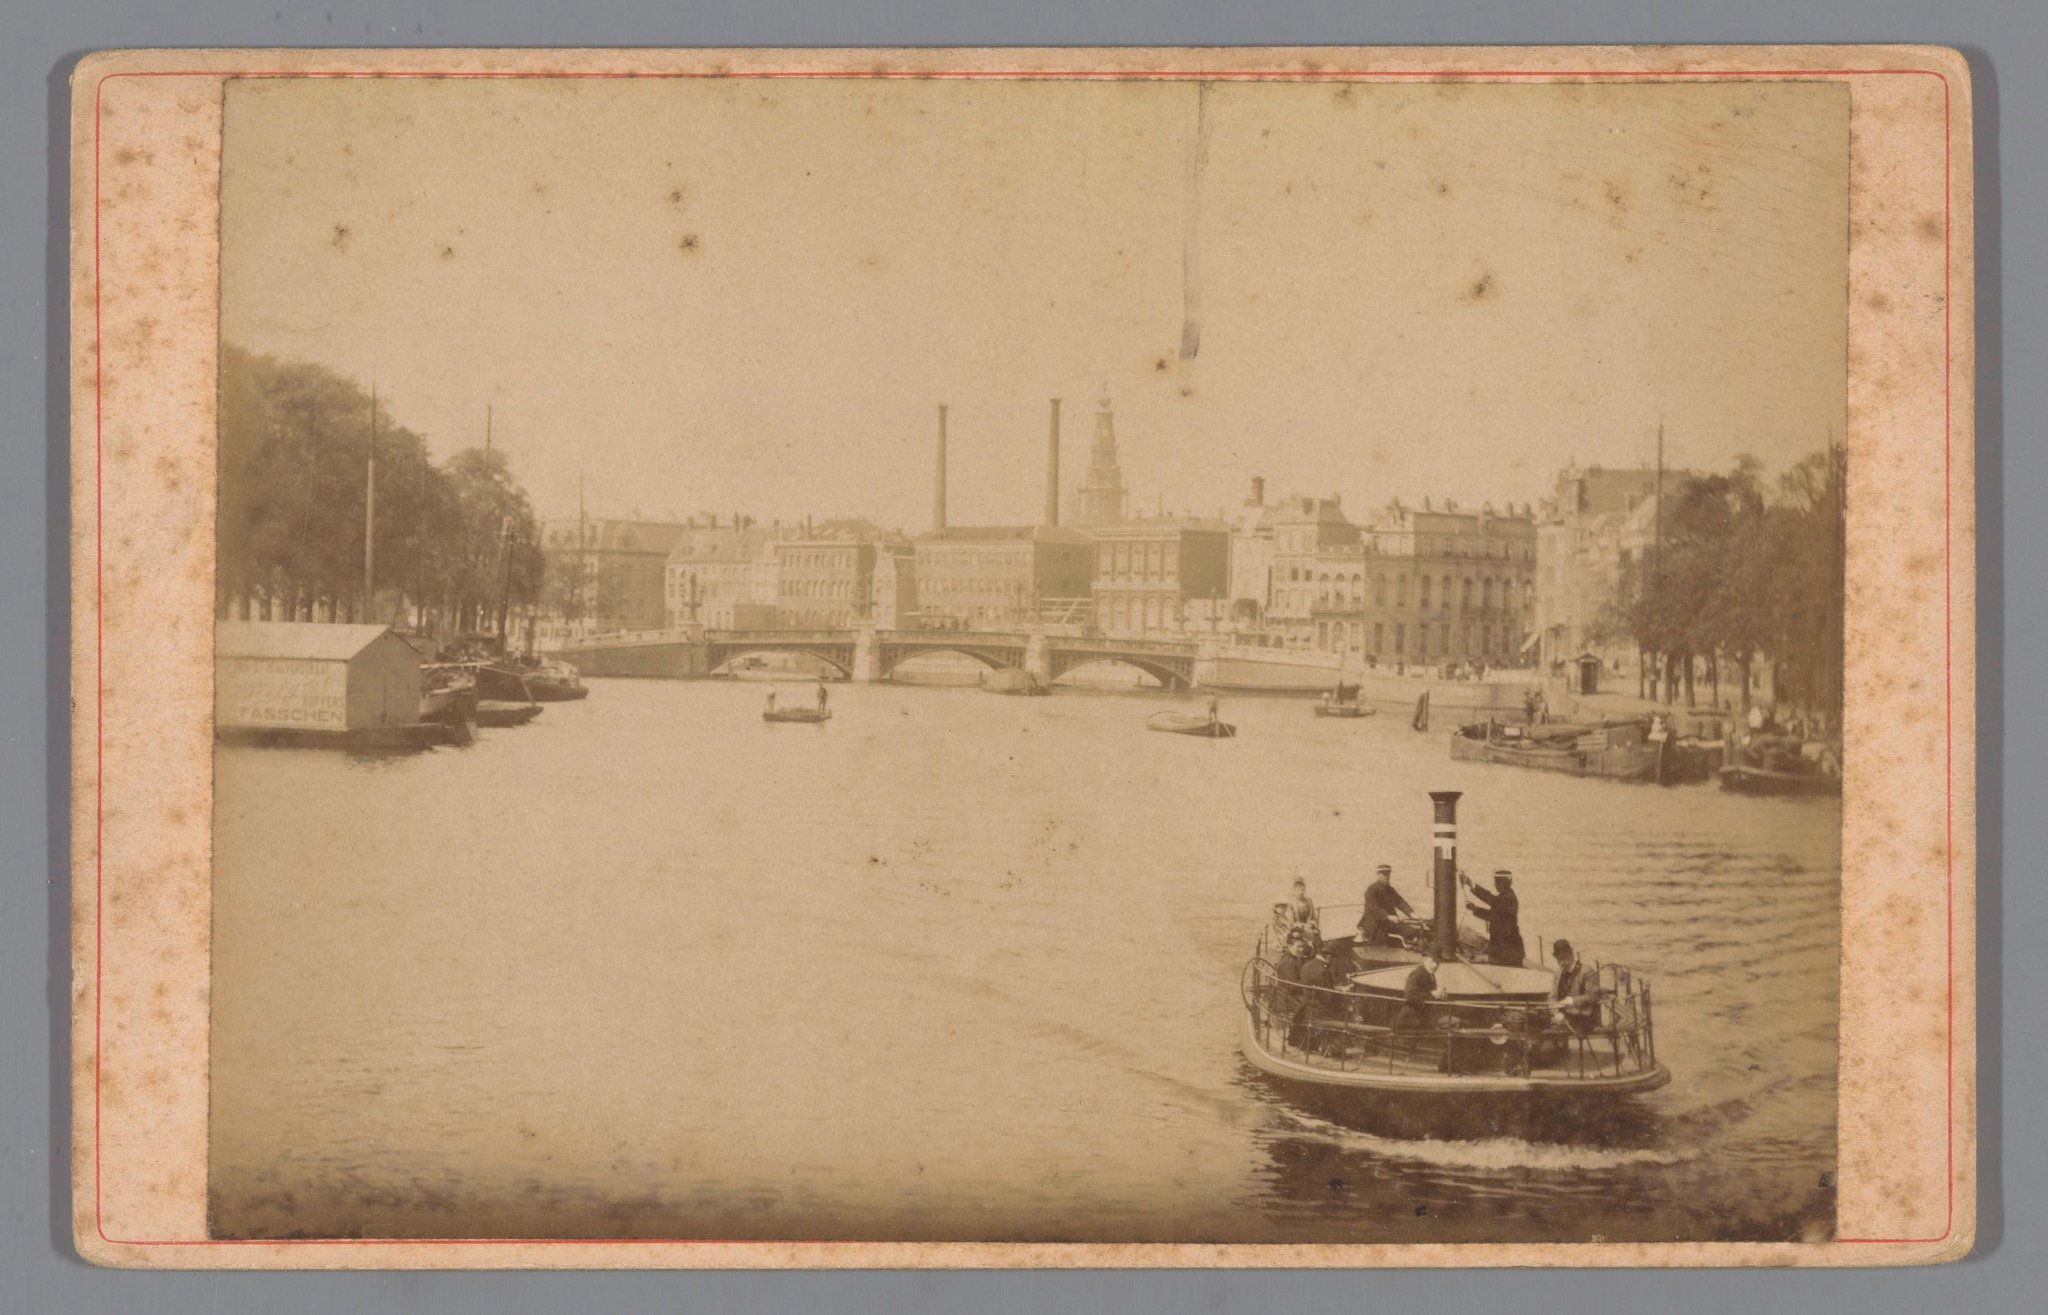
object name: cabinet photograph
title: Gezicht op de Blauwbrug over de Amstel te Amsterdam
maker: Anonymous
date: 1883-1900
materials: cardboard, photographic support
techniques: albumen print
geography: amsterdam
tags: city-view in general; 'veduta', canals, waters (in city), bridge in city across river, canal, etc.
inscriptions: inscription: ‘Amstel’